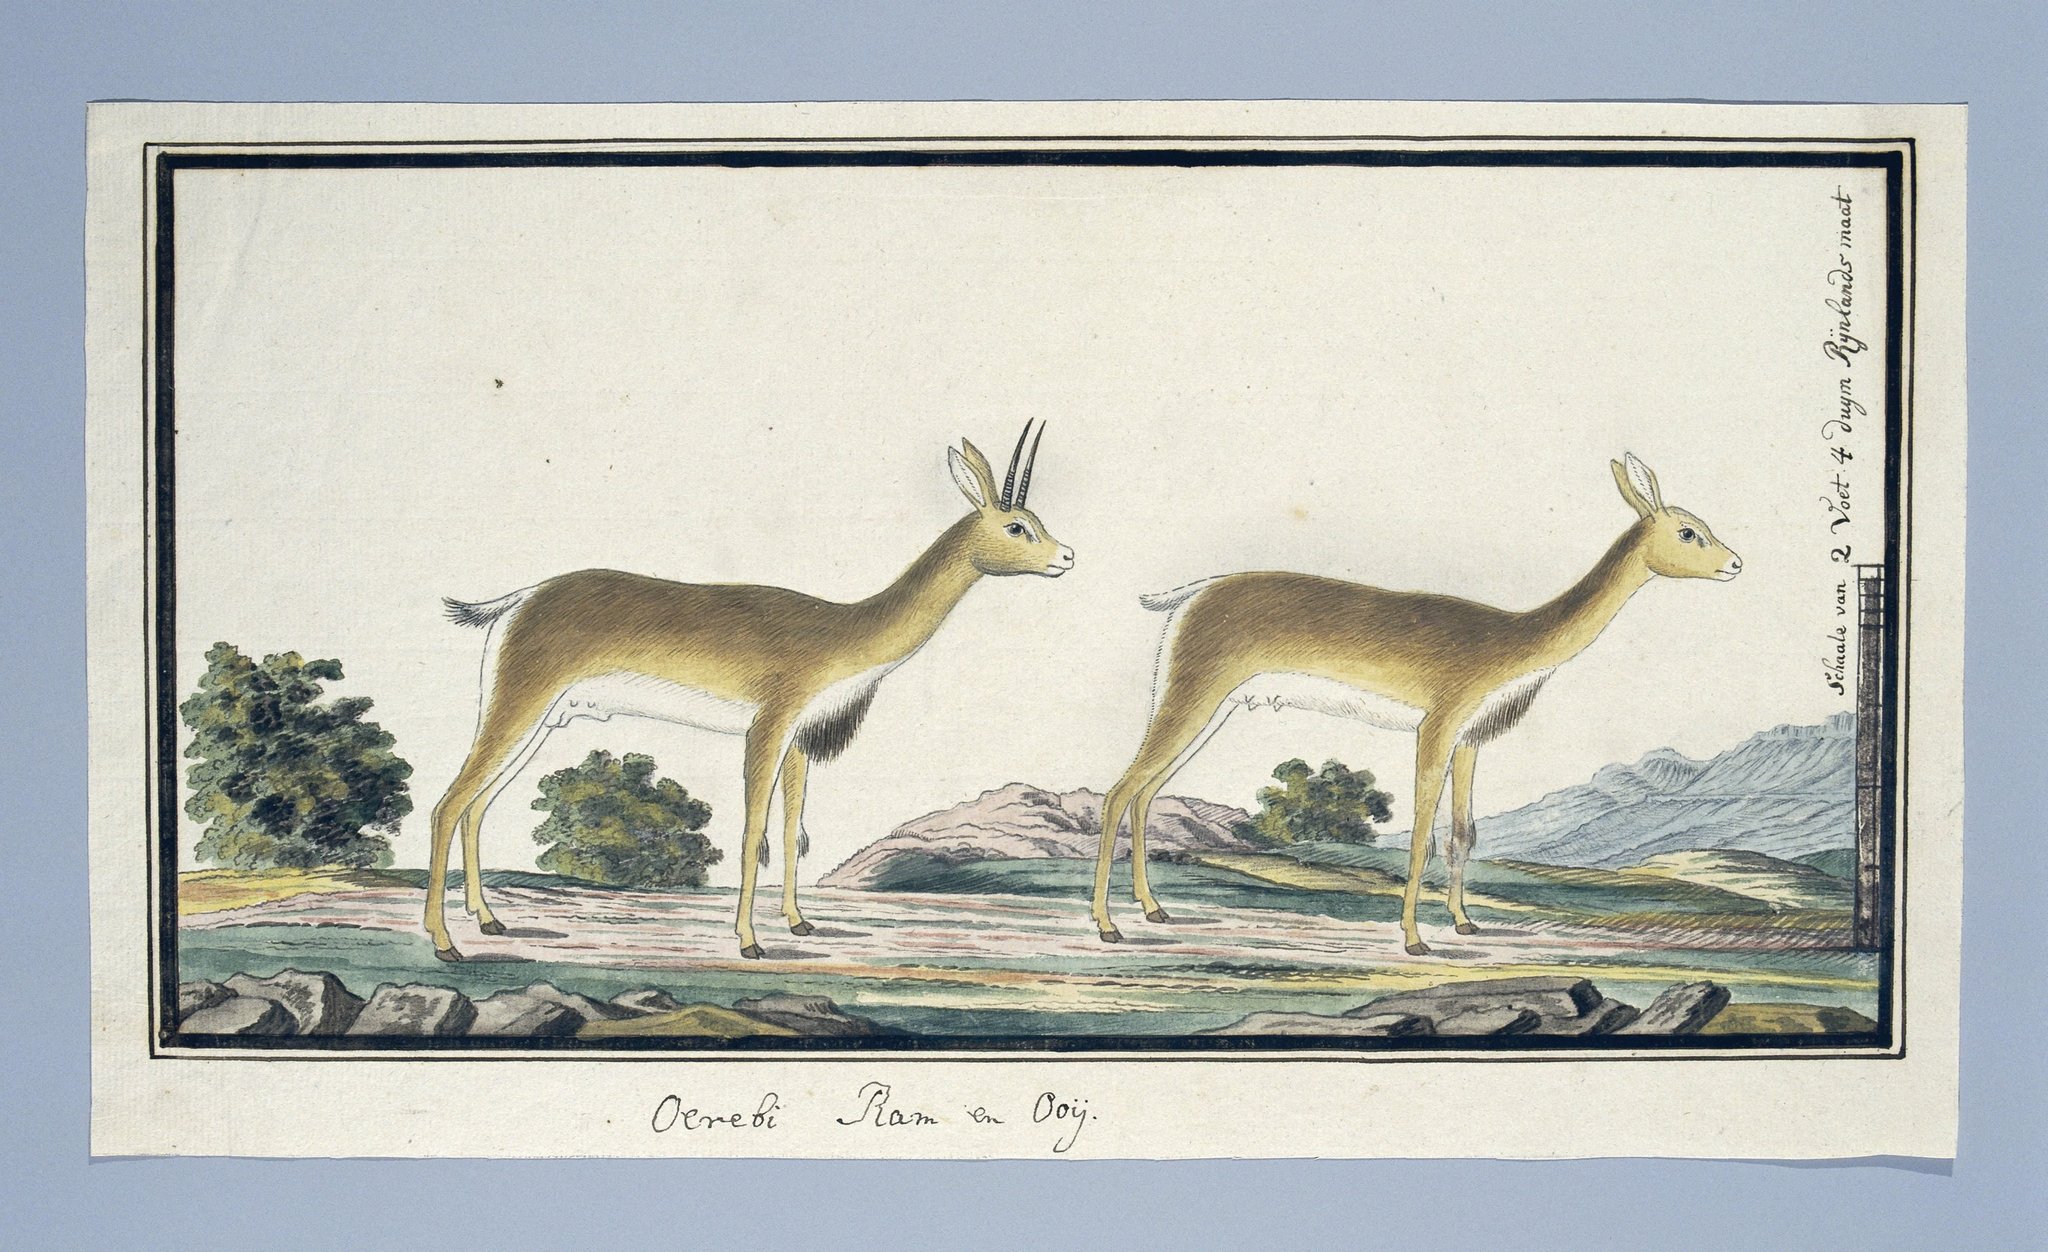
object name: album leaf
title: Ourebia ourebi (Oribi)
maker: robert jacob gordon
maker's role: draughtsman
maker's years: 1743-1795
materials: paint, ink, paper, pencil, watercolor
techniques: brush, pen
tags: animals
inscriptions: annotation: ‘Oerebi Ram en Ooij; schaalverdeling met: Schaale van 2 Voet 4 duijm Rijnlands maat’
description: Oerebi (Ourebia ourebi): ram en ooi; met schaalverdeling in Rijnlandese maat.